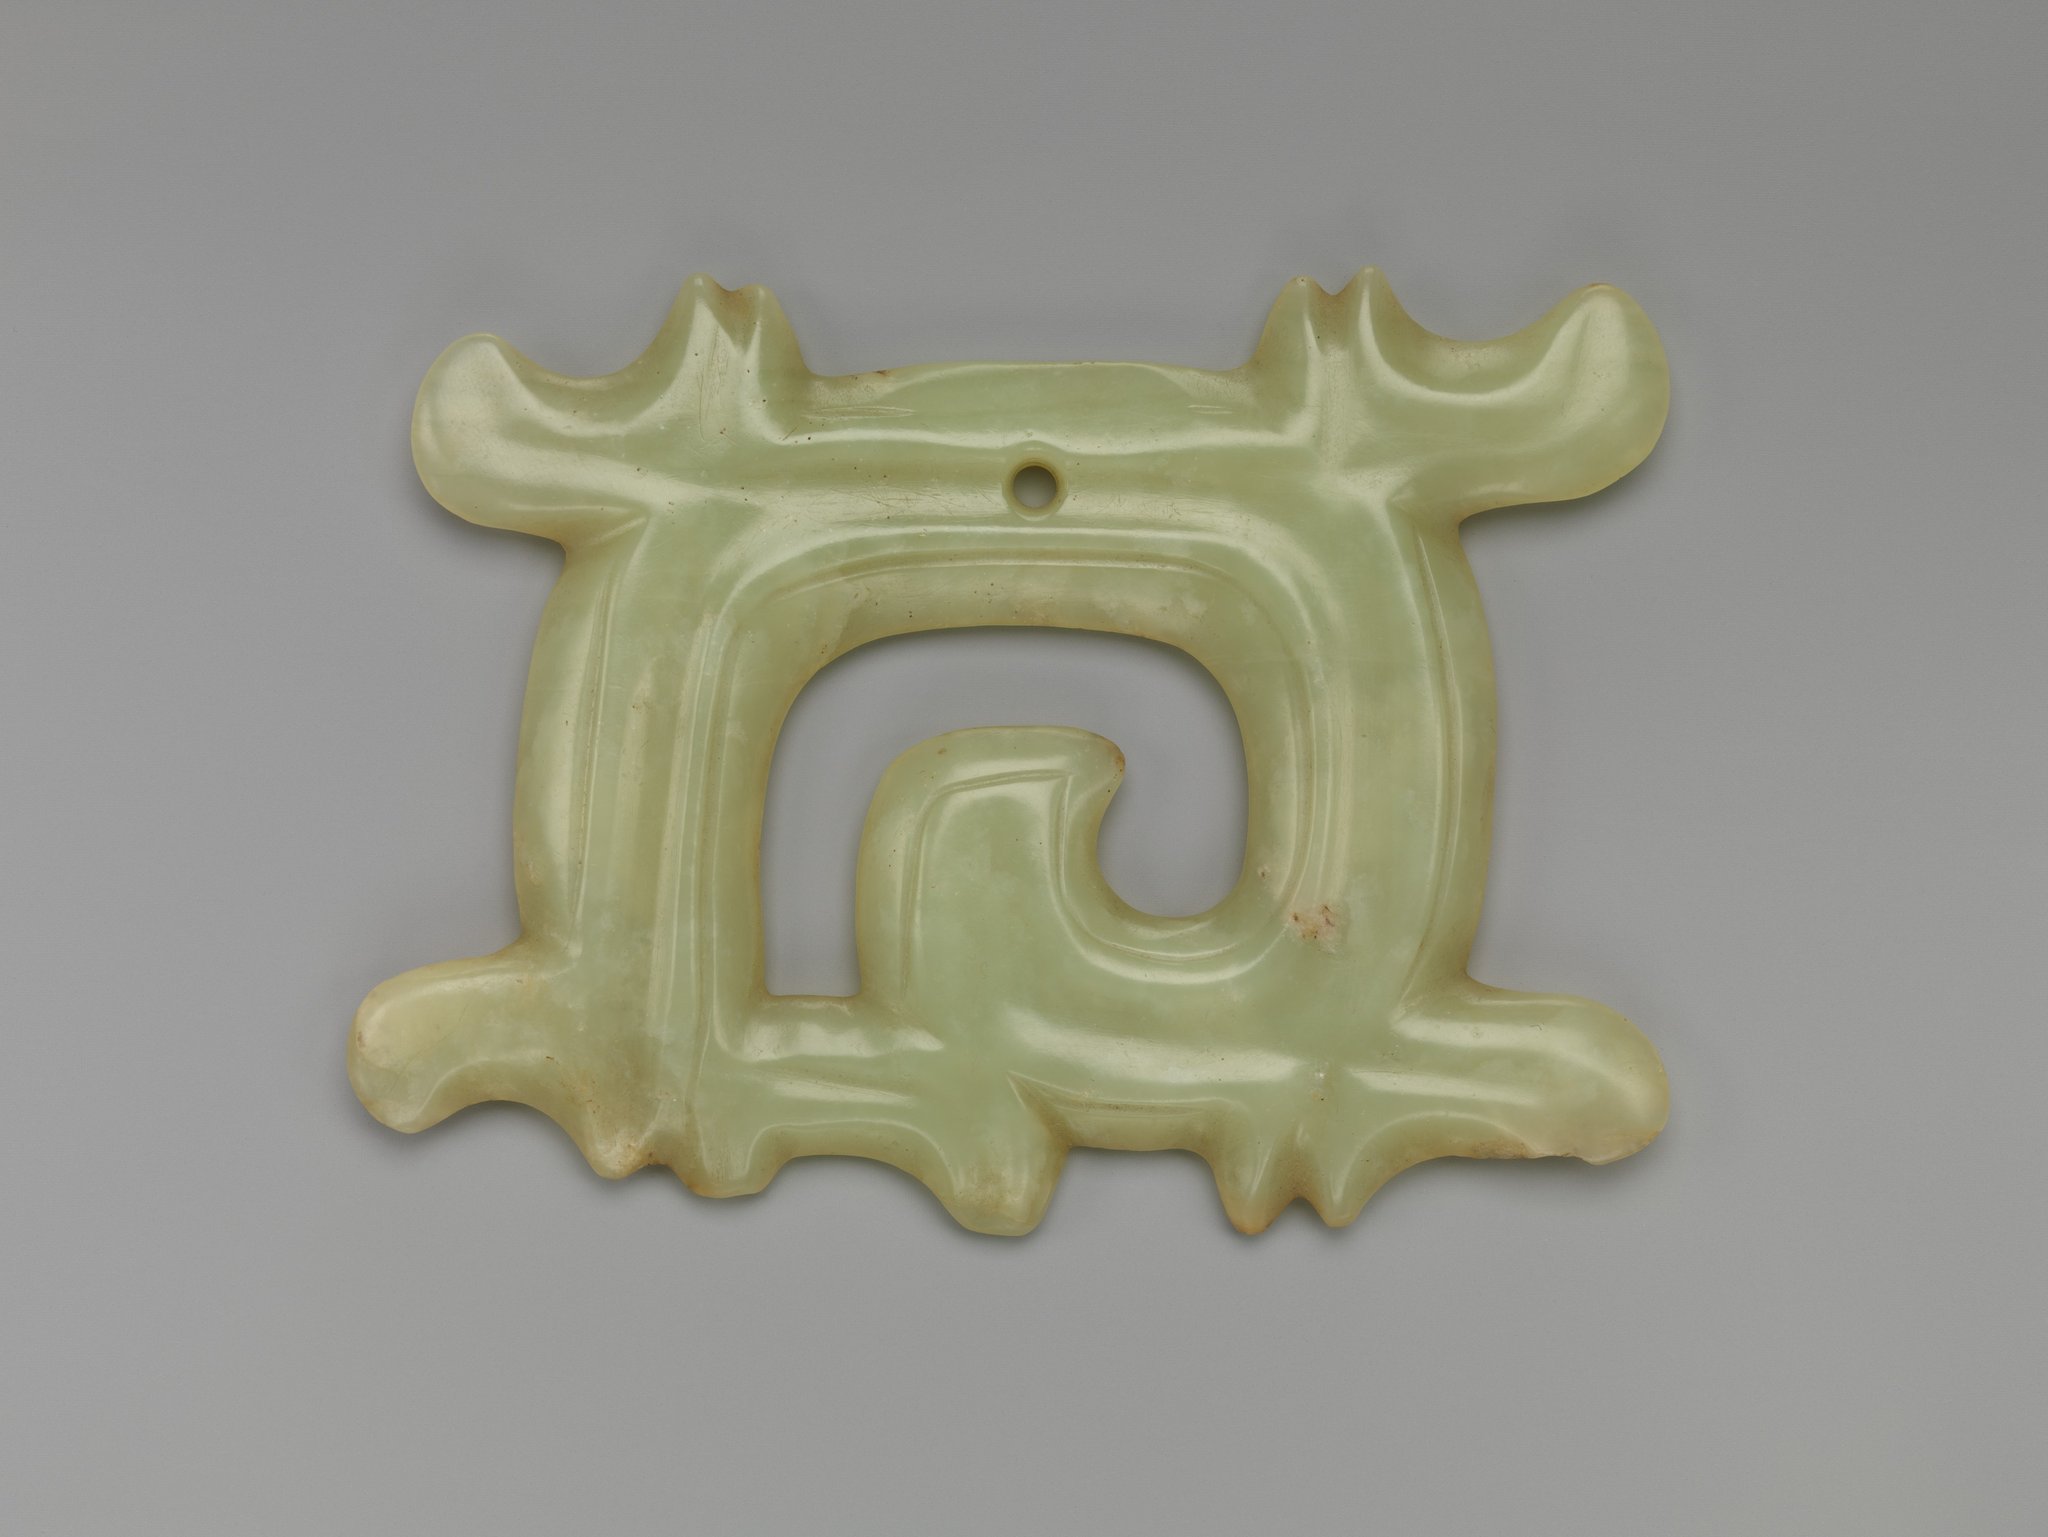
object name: plaque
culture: chinese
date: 3500-2000 BCE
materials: jade